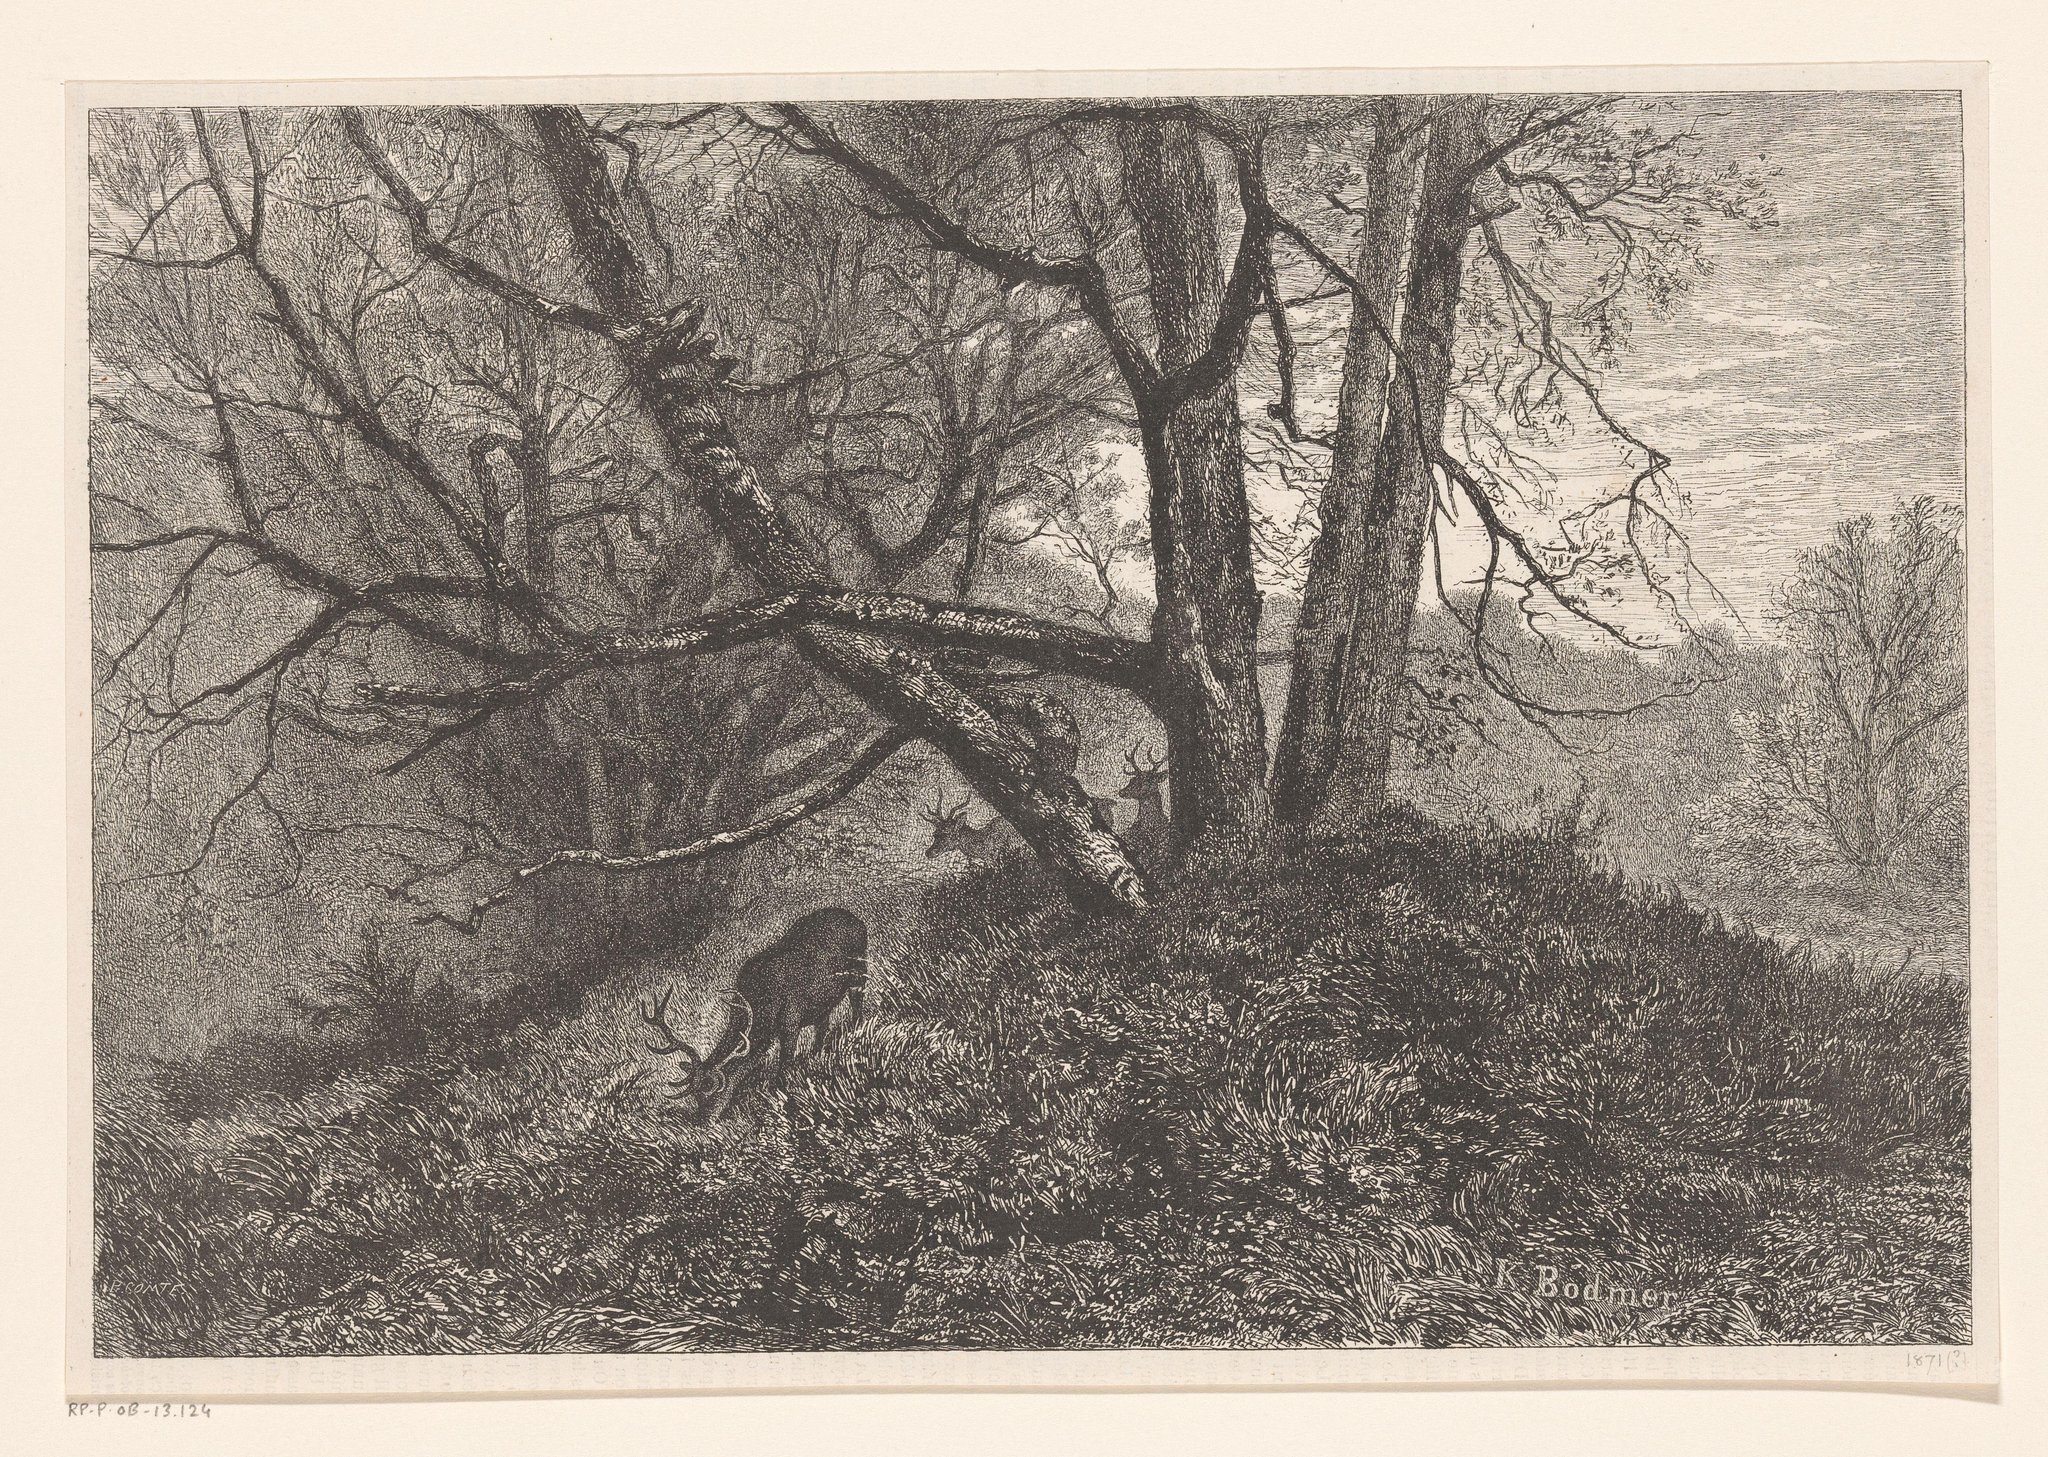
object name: illustration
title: Cerfs au gagnage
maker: karl bodmer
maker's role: draughtsman, painter, print maker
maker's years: 1809-1893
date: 1872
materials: paper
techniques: lithography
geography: barbizon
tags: hoofed animals: deer, forest, wood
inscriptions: collector's mark: Lugt 2228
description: Prent afkomstig uit: L'illustration 59 (1872), p. 301.